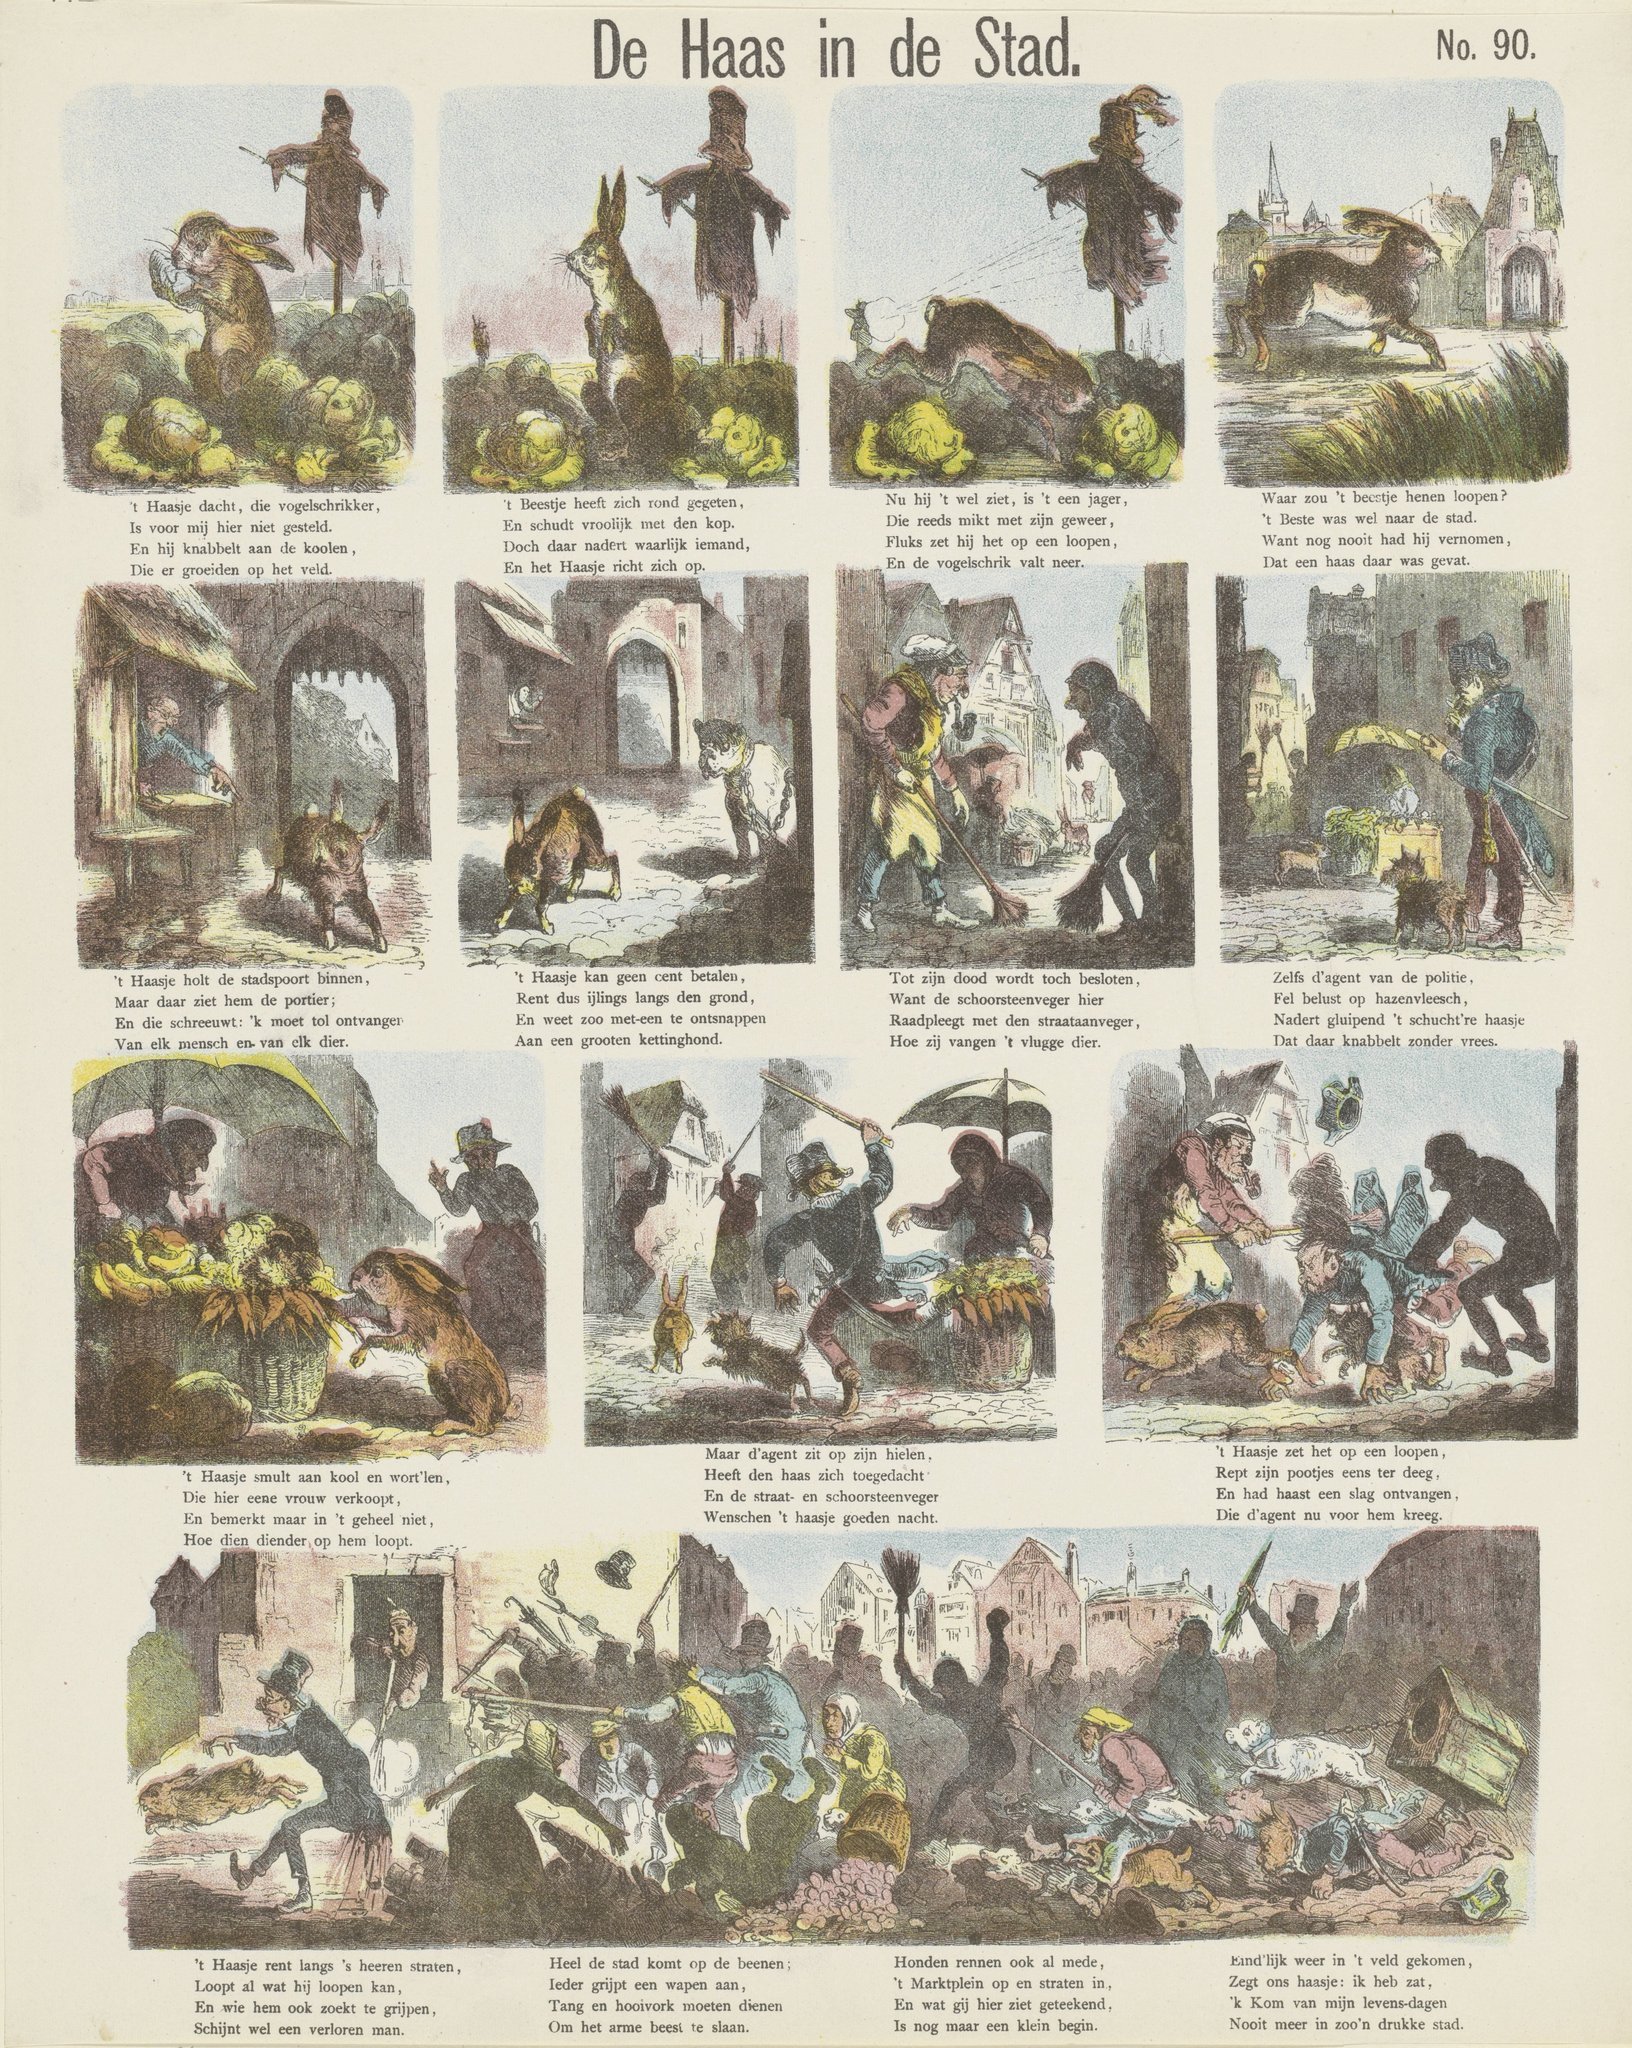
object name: print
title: Meijer's prenten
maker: Anonymous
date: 1881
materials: paper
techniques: lithograph, letterpress printing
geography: amsterdam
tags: rodents: hare, street-fights, riots, street, city-gate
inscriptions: collector's mark: Lugt 2760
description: Blad met 12 voorstellingen over een haas in de stad. Onder elke afbeelding een onderschrift. Genummerd rechtsboven: No. 90.